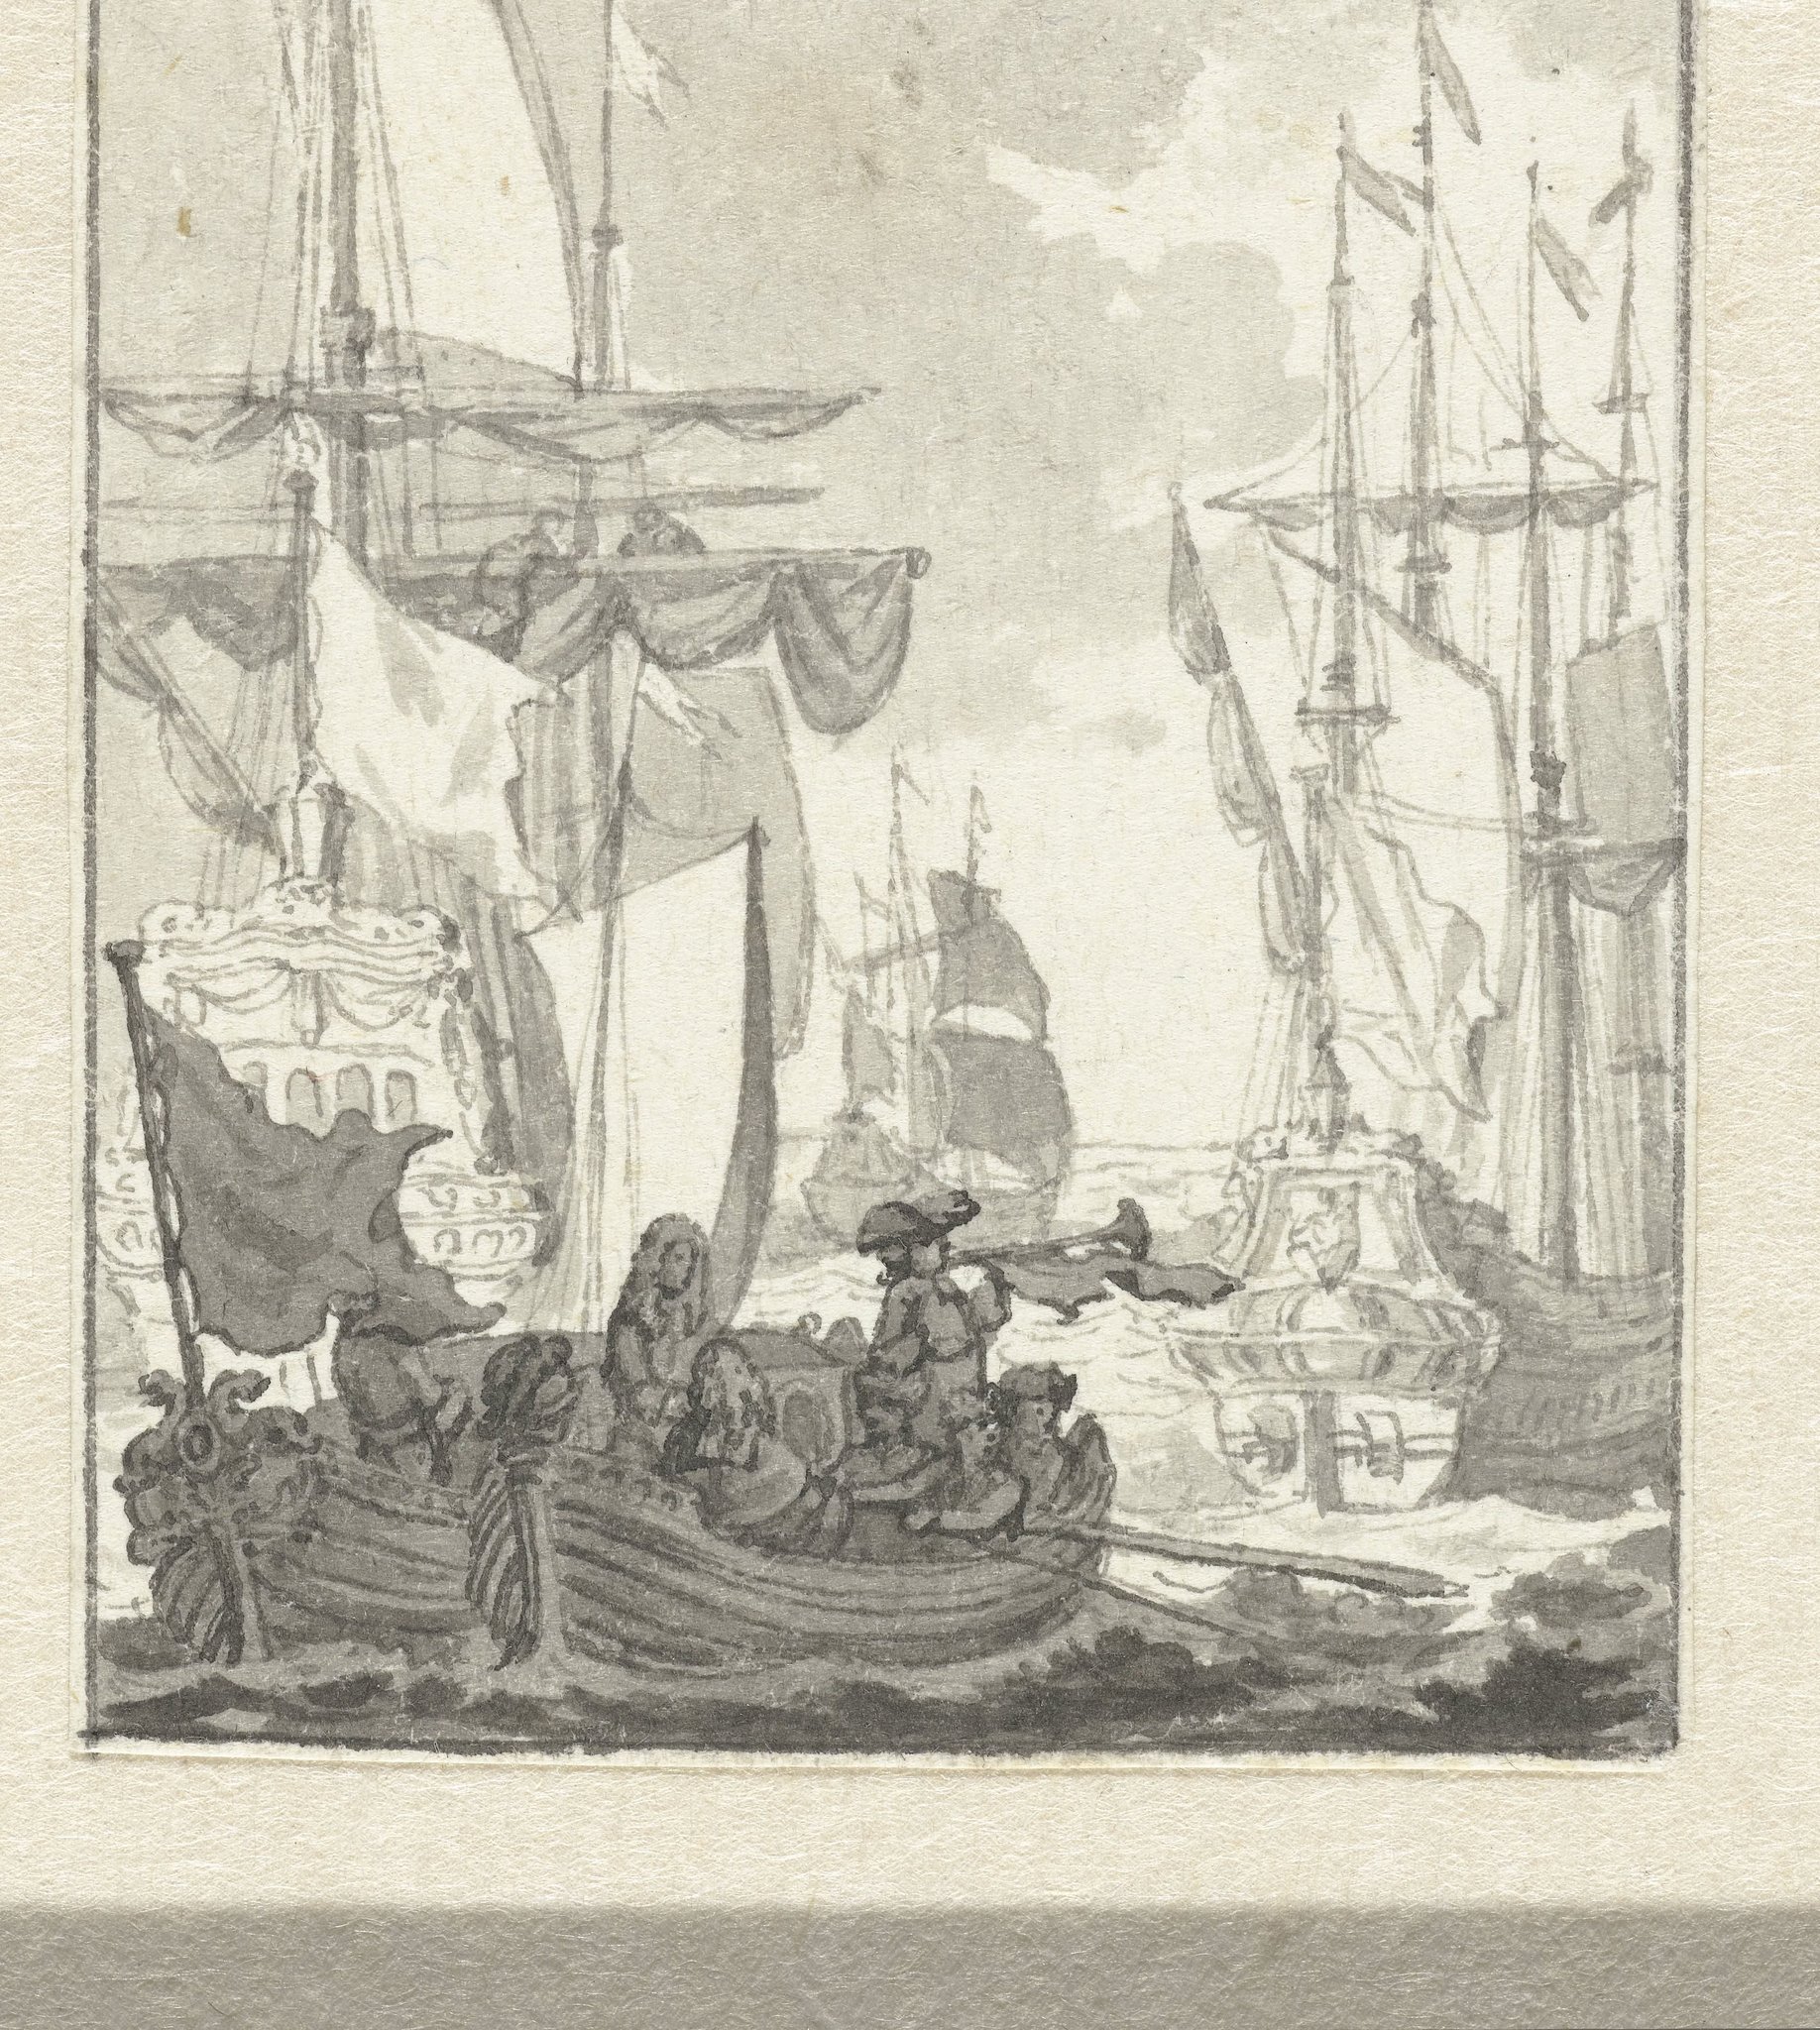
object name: design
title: In 't Jaar 1688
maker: Anonymous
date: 1789-1810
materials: ink, paper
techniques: brush, pen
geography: netherlands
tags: the hague, william iii (prince of orange and king of england, scotland, and ireland), departure ~ travelling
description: Vertrek van Willem III naar de vloot die hem naar Engeland zal brengen, 11 november 1688.